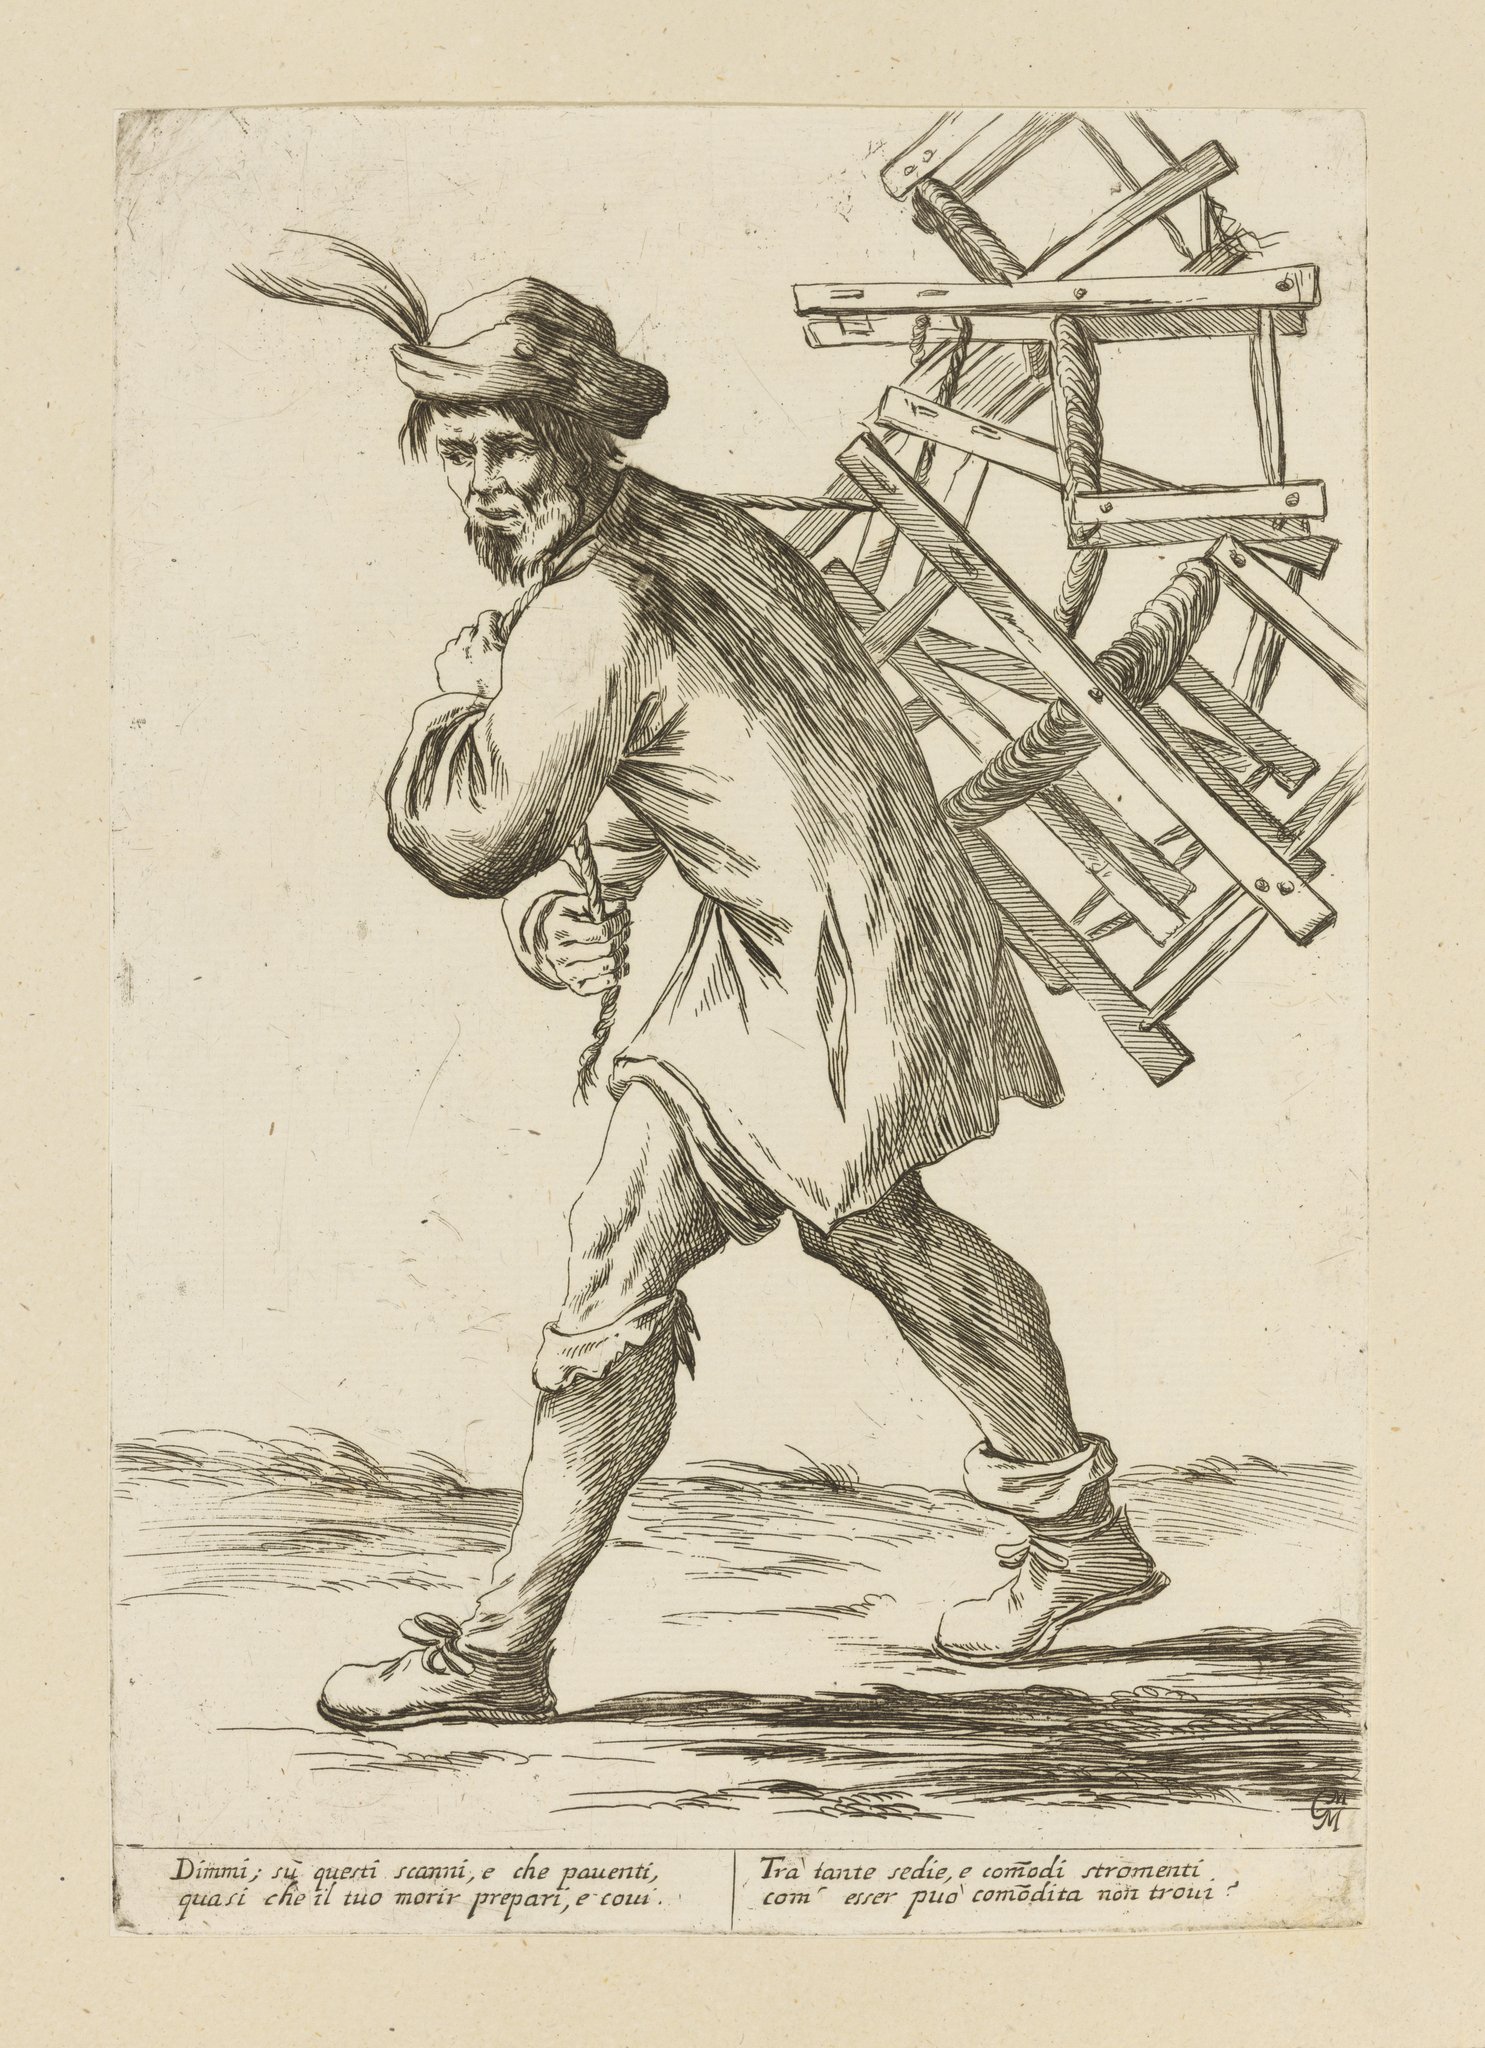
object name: print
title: Vendor of Chairs, from Di Bologna l'Arti per via D'An.ibal' Ca.rac, plate 6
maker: giuseppe maria mitelli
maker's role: artist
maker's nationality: italian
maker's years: 1634-1718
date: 1660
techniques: etching